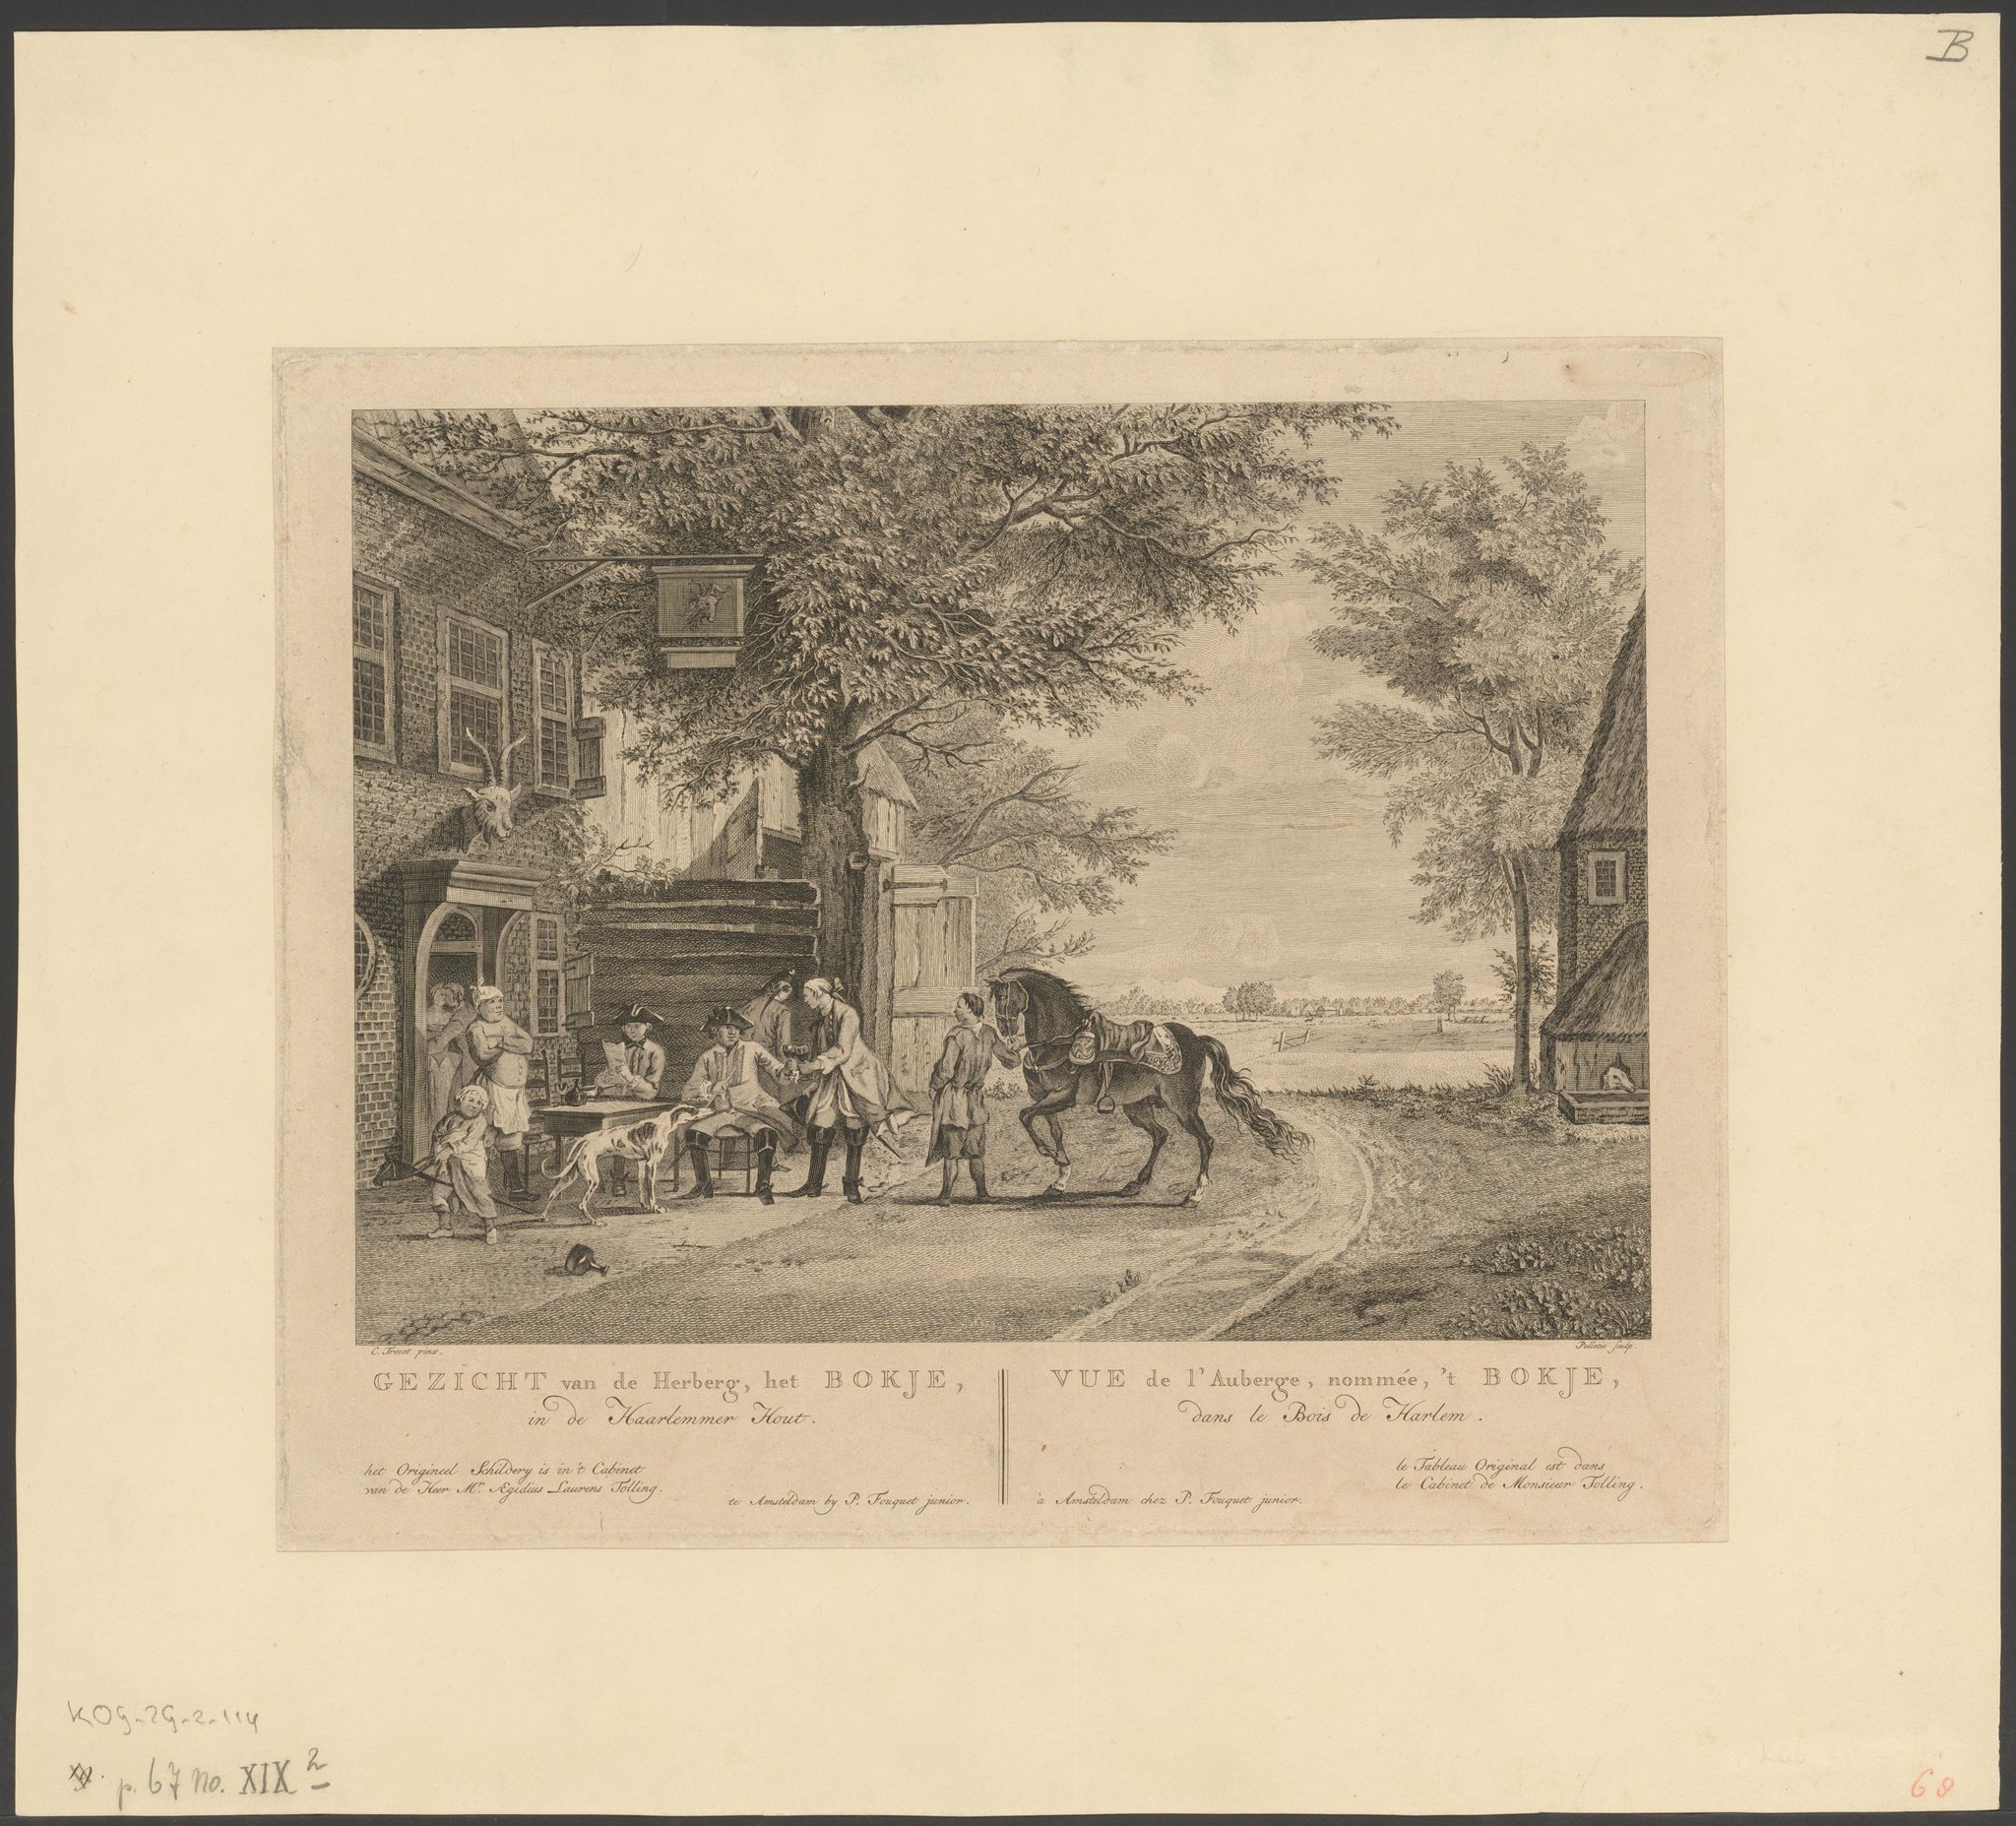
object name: print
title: Gezicht van de Herberg, het Bokje, in de Haarlemmer Hout / Vue de l'Auberge, nommée, 't Bokje, dans le Bois de Harlem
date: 1754-1764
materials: paper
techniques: engraving, etching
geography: amsterdam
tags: hotel, hostelry, inn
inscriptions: collector's mark: Lugt 2488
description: Gezicht op de herberg genaamd het Bokje ('t Bokki), in de Haarlemmerhout. Verschillende militairen zitten aan tafels op het terras voor de herberg, een knecht houdt een paard bij de leidsels.